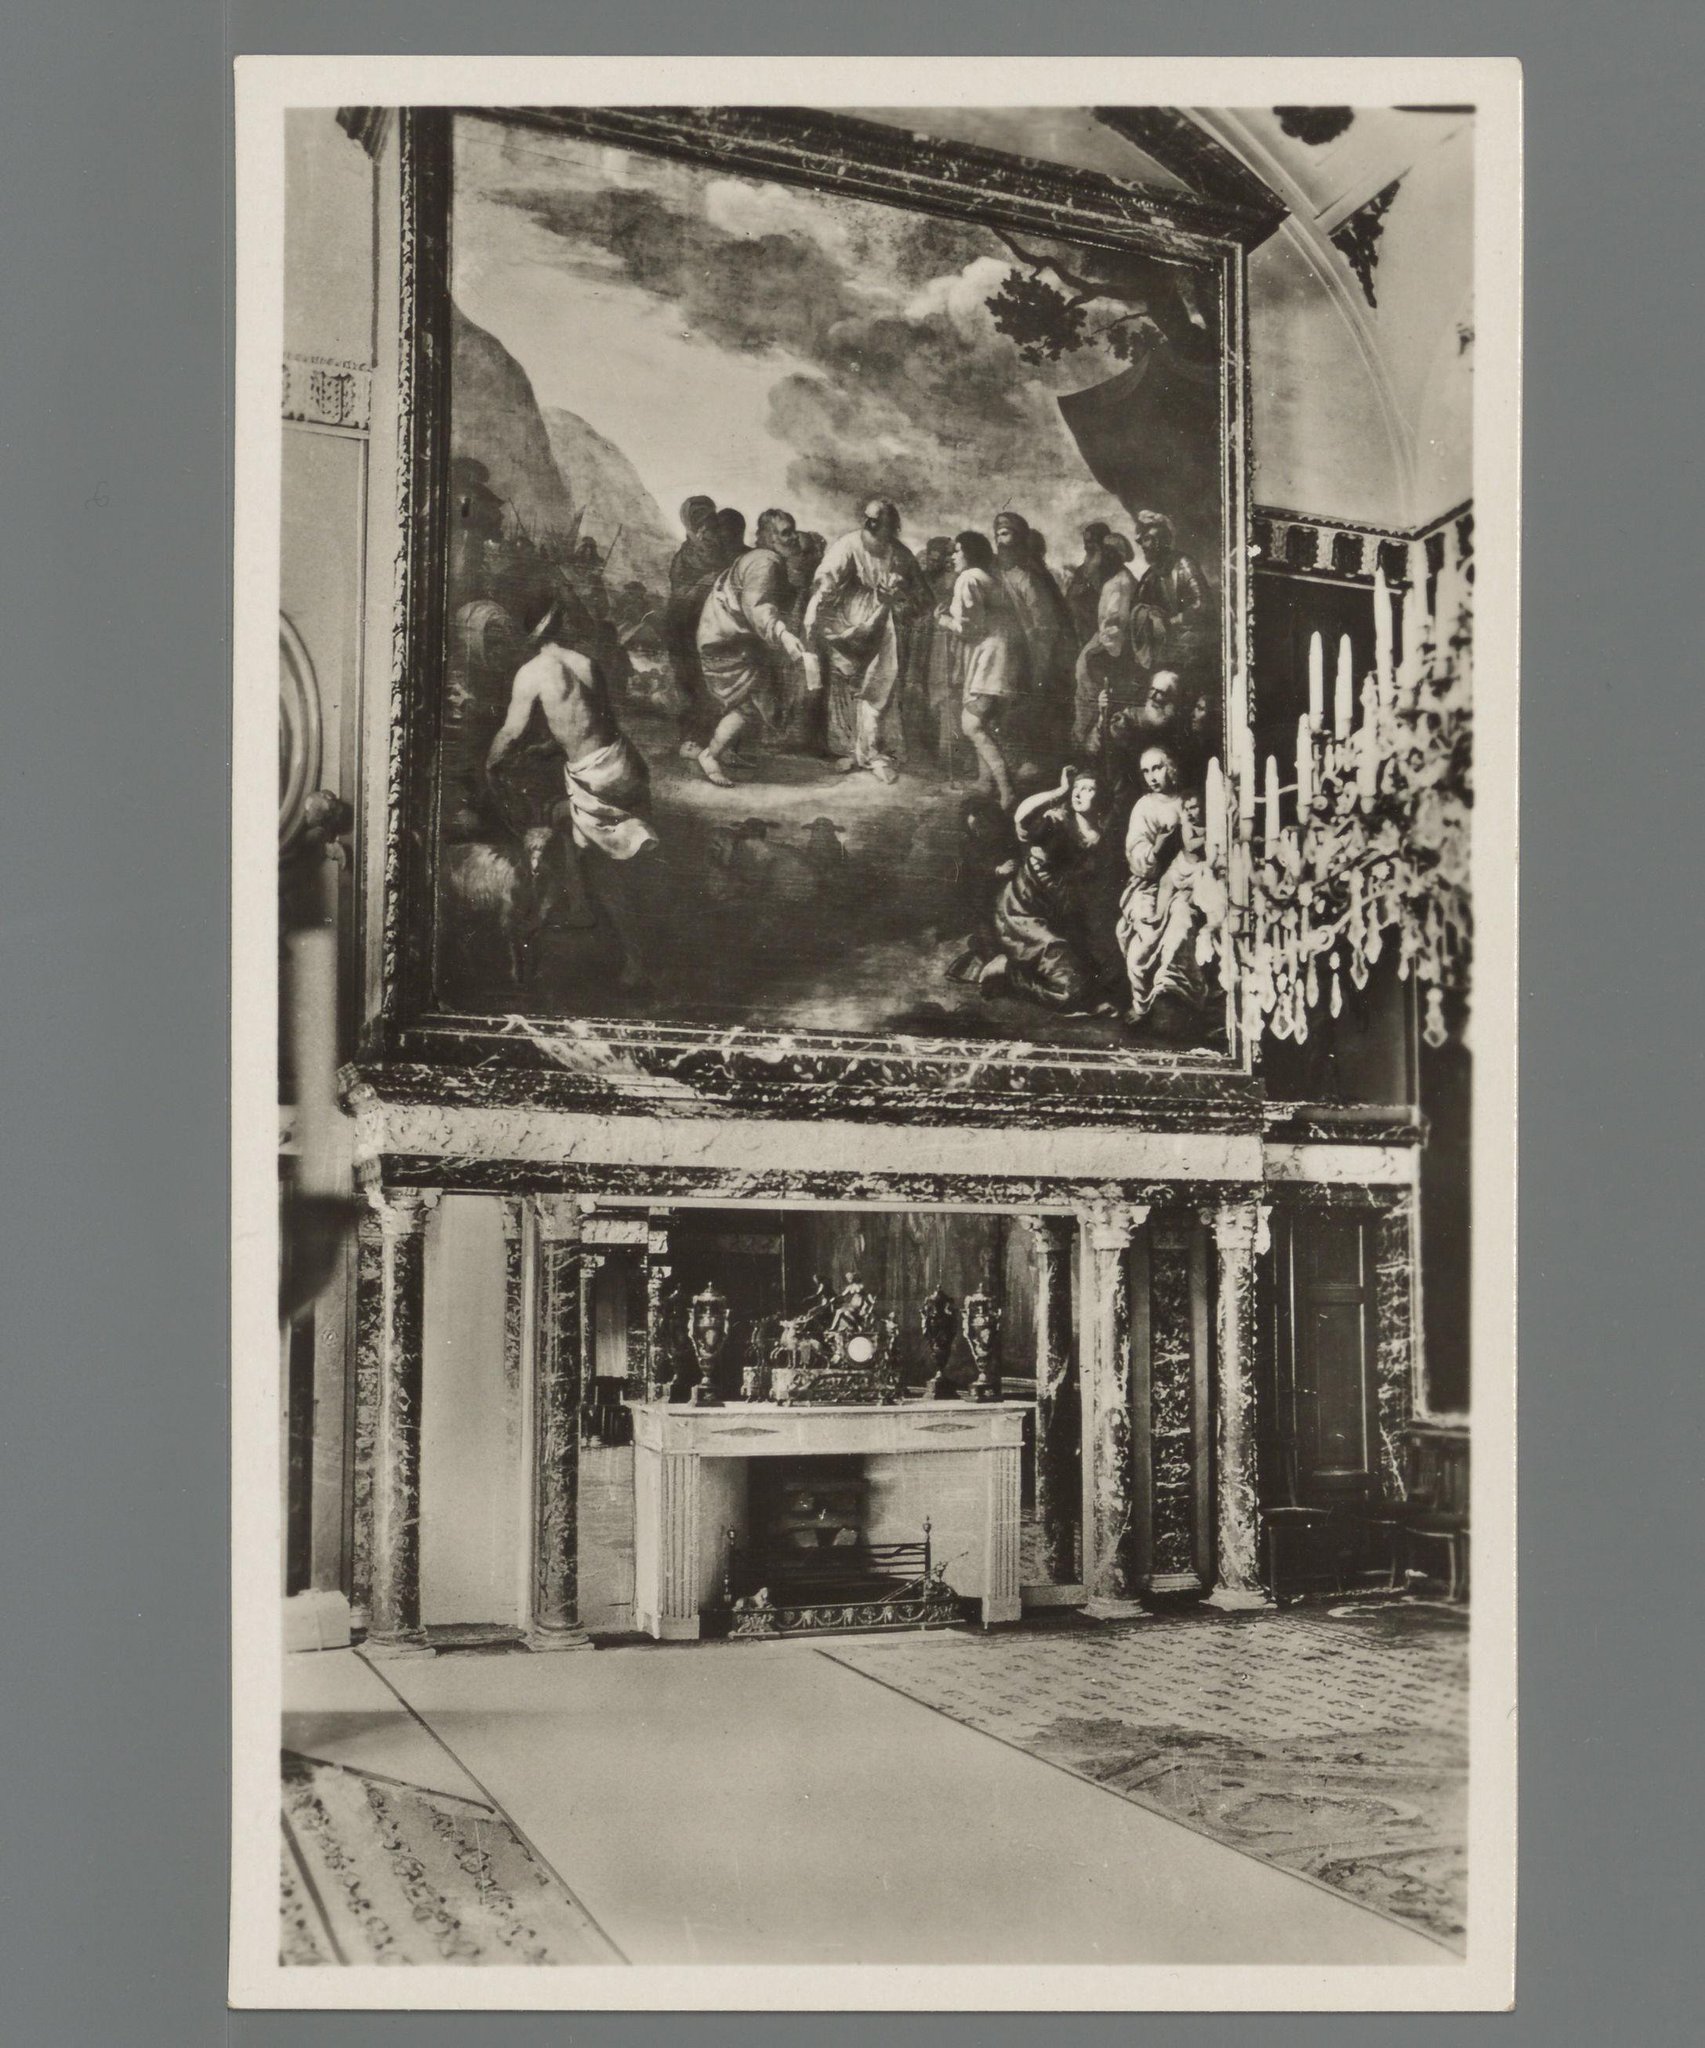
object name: ansichtkaart, prentbriefkaart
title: Koninklijk Paleis Amsterdam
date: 1932-1947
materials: photographic support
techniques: photography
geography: the hague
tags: palace - aa - civic architecture: inside, decorations (interior of the house), picture, painting, royal palace of amsterdam